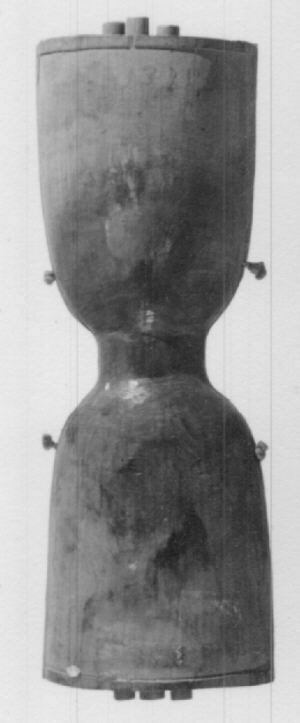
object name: rattle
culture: congolese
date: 1867-1900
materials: wood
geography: upper congo